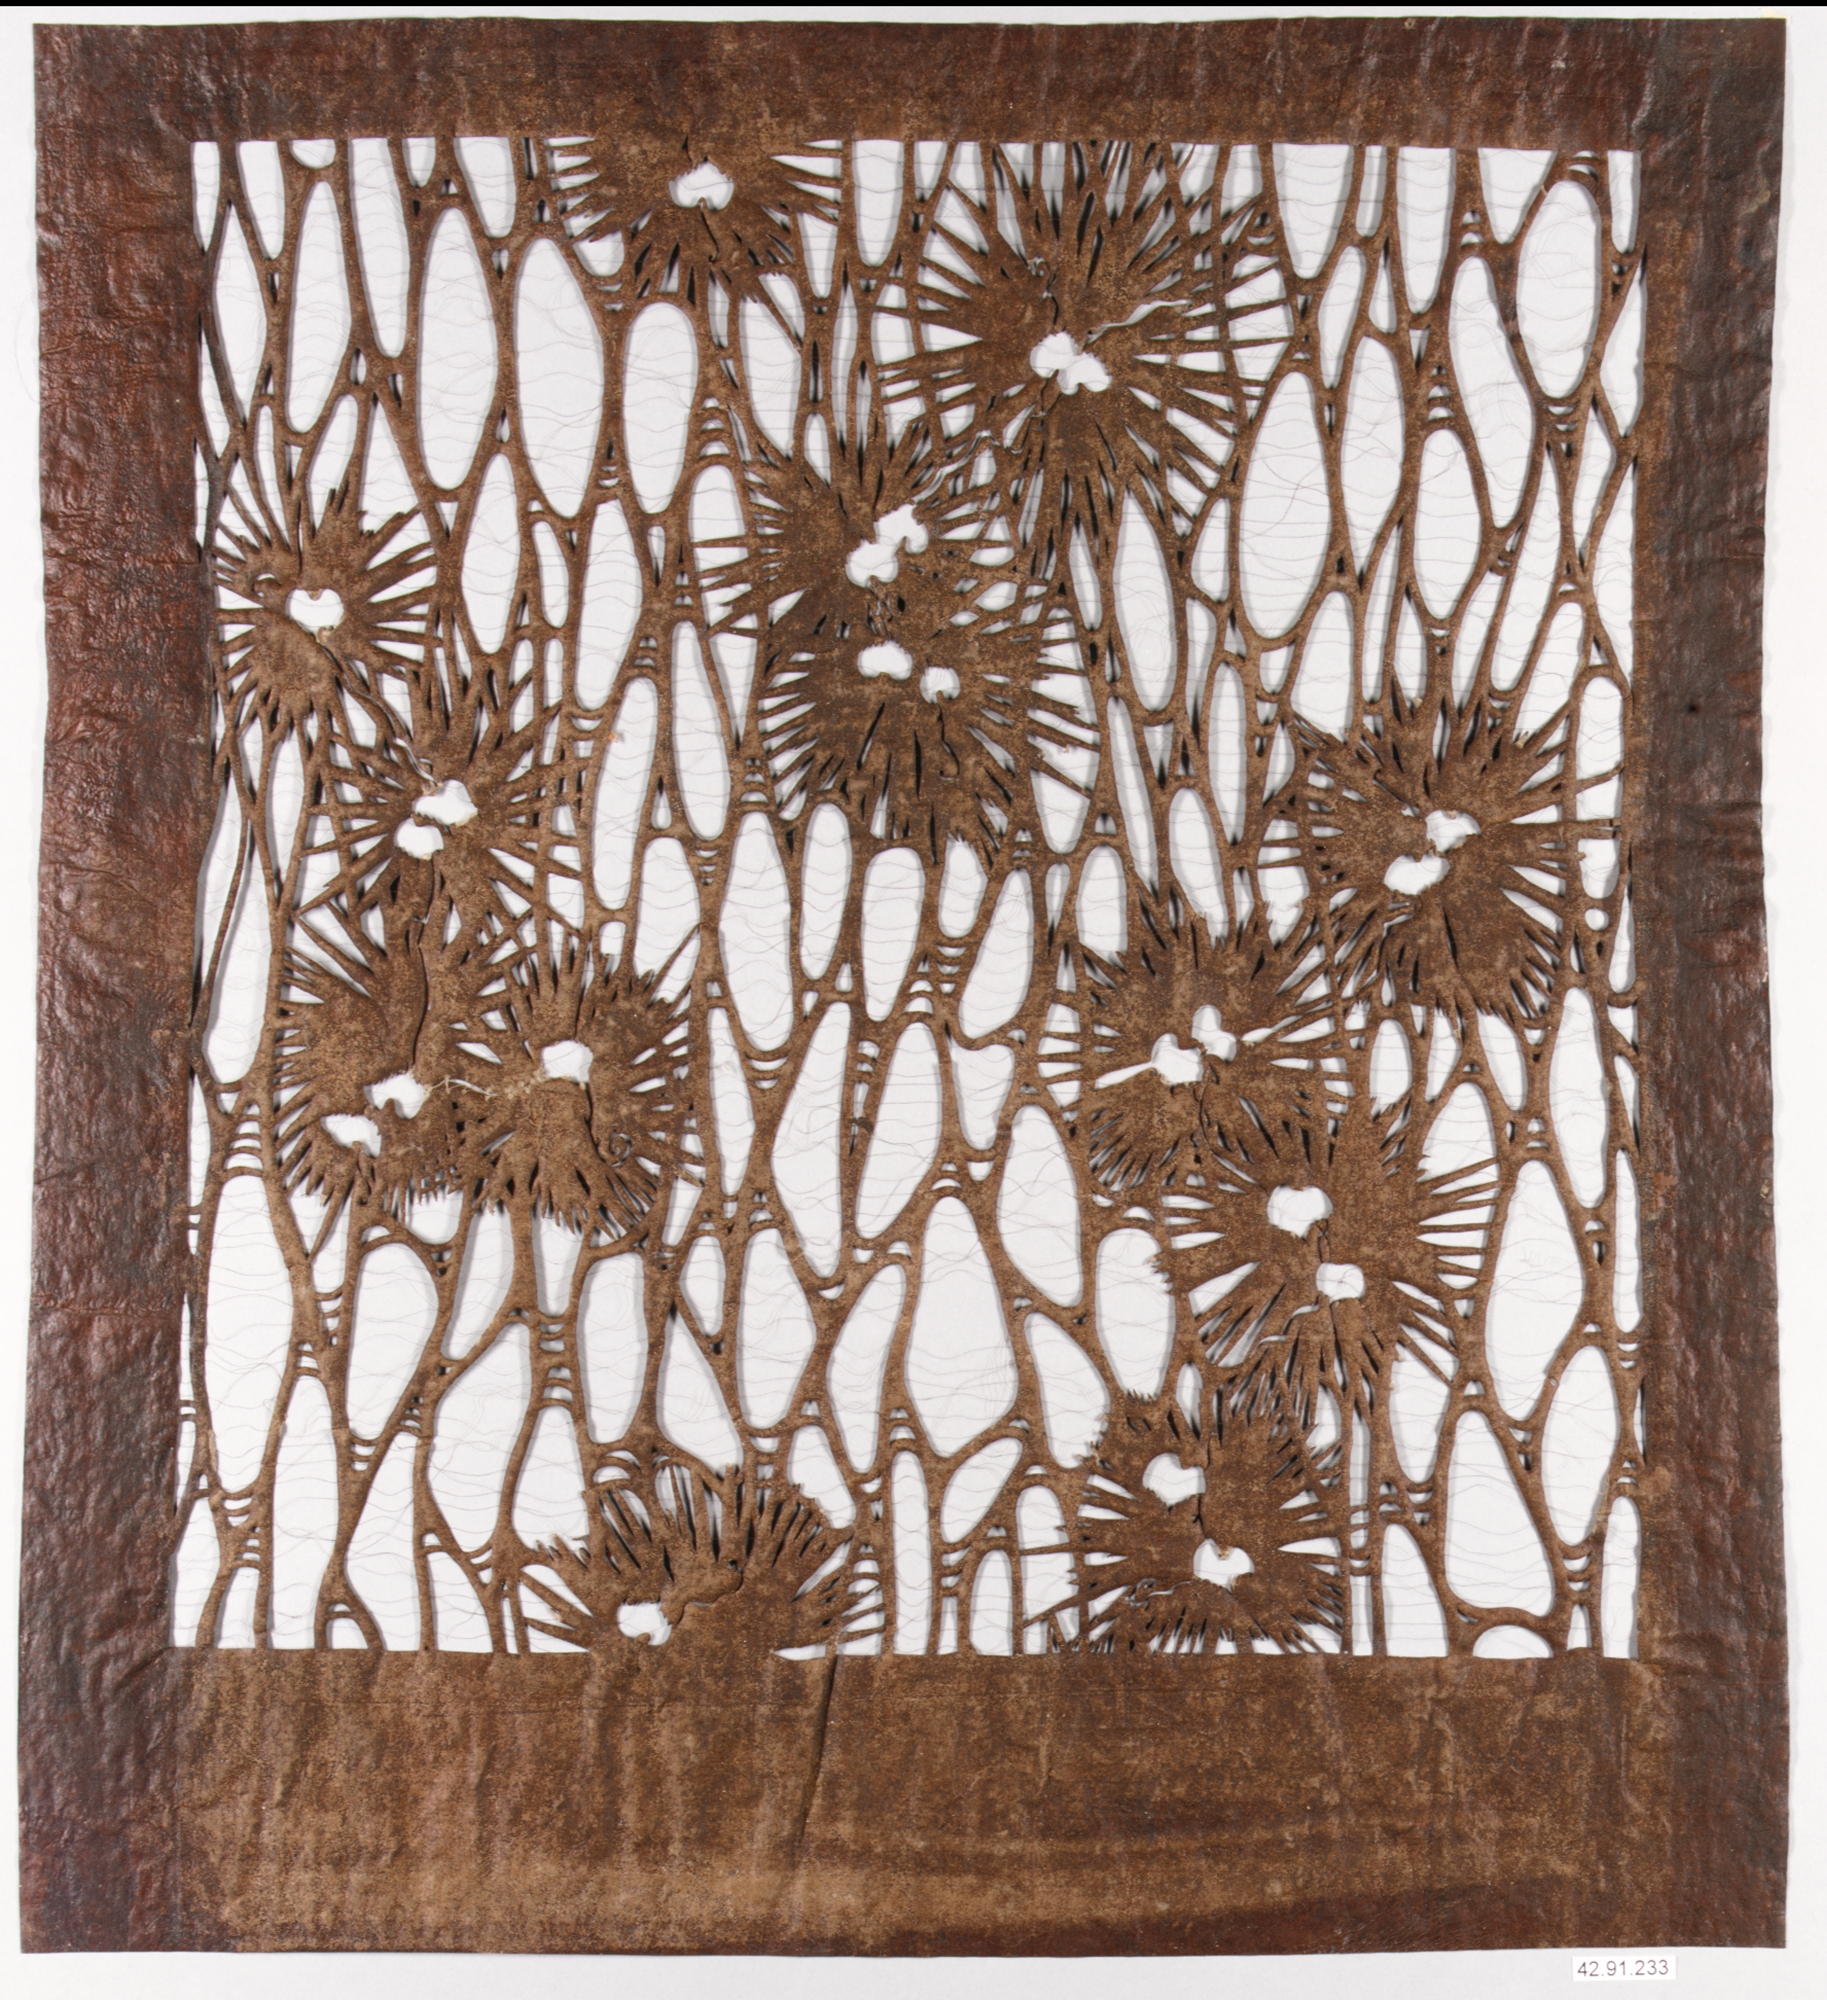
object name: stencil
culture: japanese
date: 1801-1900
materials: paper